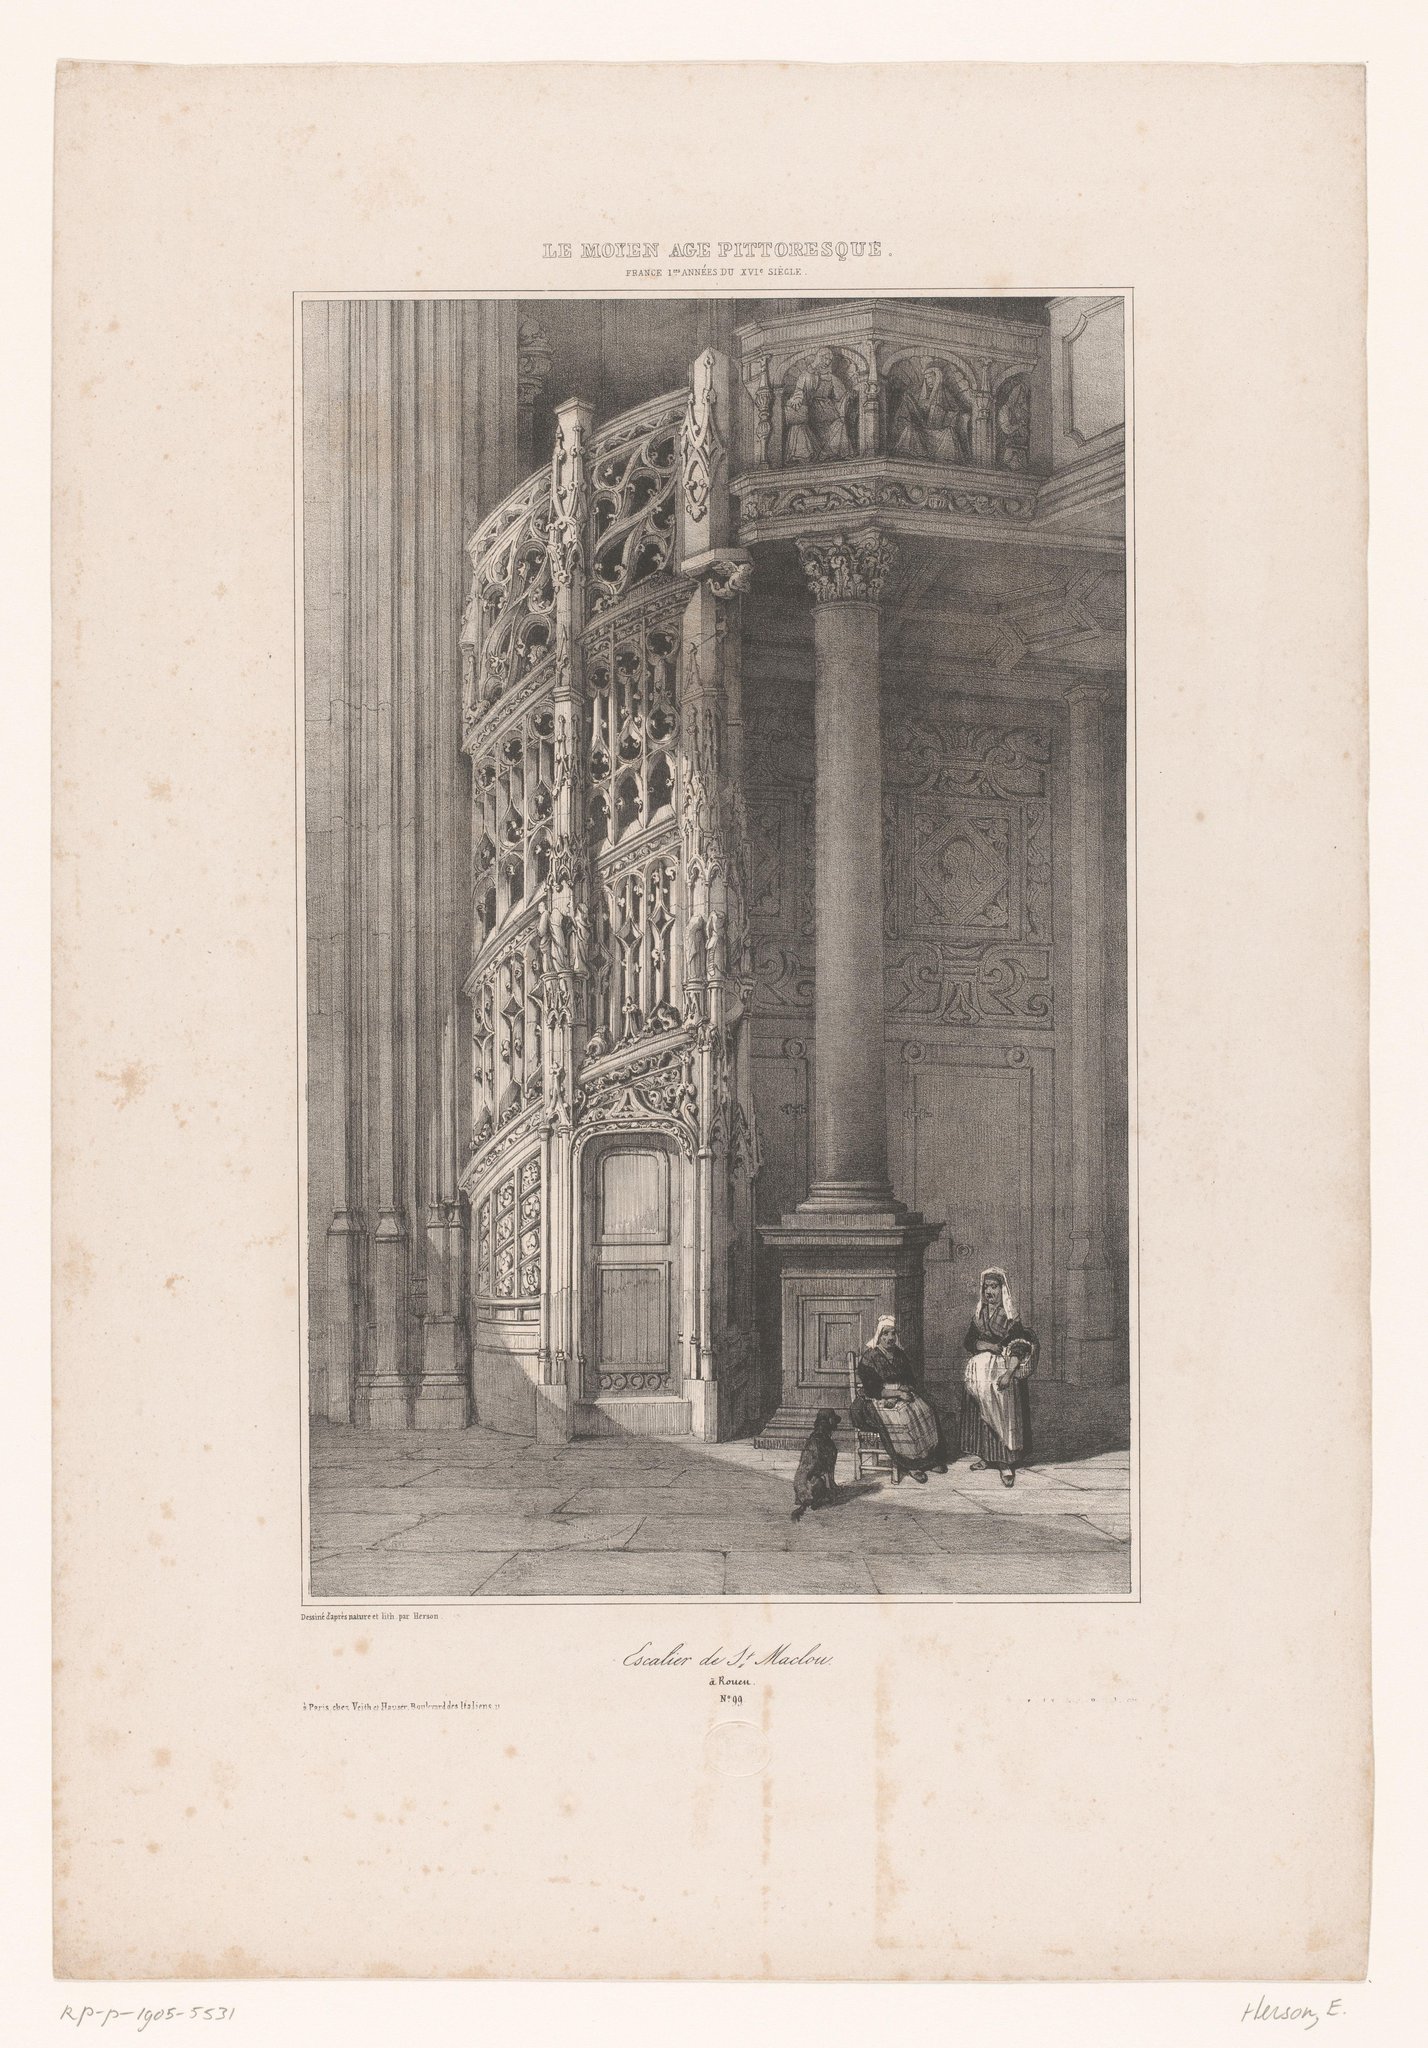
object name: print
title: Pittoreske middeleeuwen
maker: emile herson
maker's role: print maker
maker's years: 1805-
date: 1838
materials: paper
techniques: lithograph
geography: paris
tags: parts of church interior, staircase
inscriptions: check stamp: Lugt 4211, collector's mark: Lugt 2228a